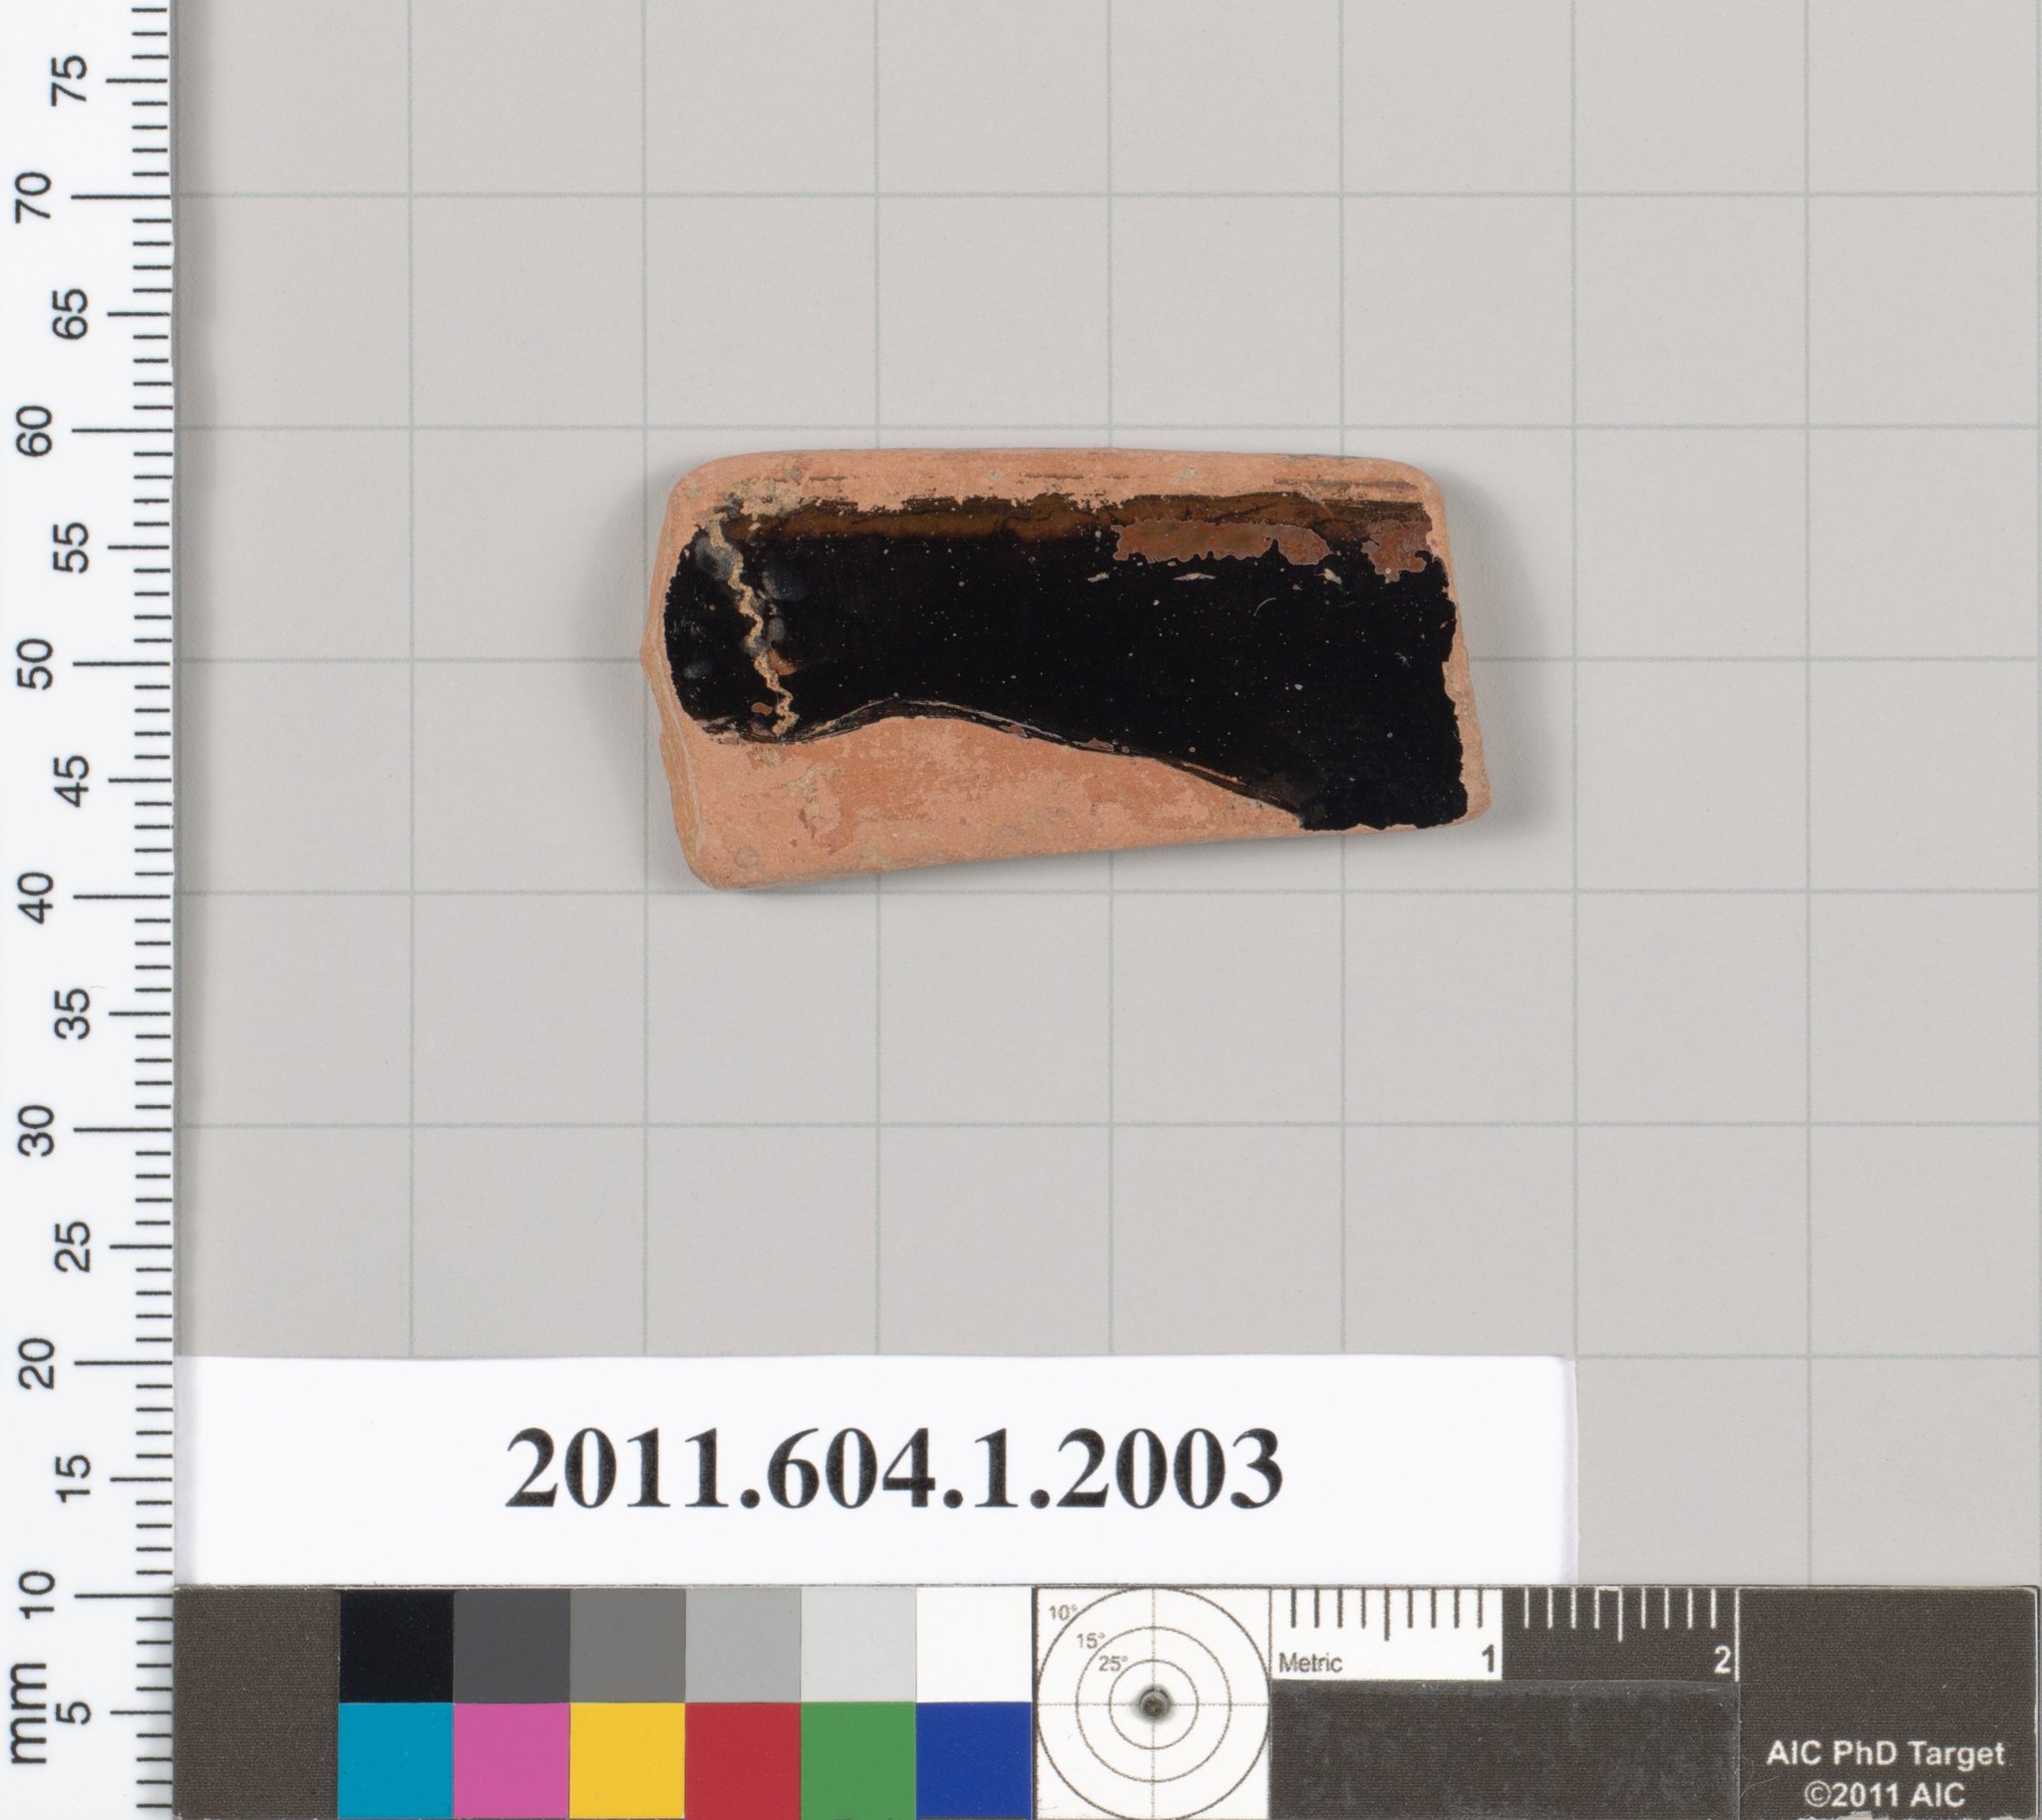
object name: kylix fragment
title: Terracotta rim fragment of a kylix (drinking cup)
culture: greek, attic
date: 500-468 BCE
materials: terracotta